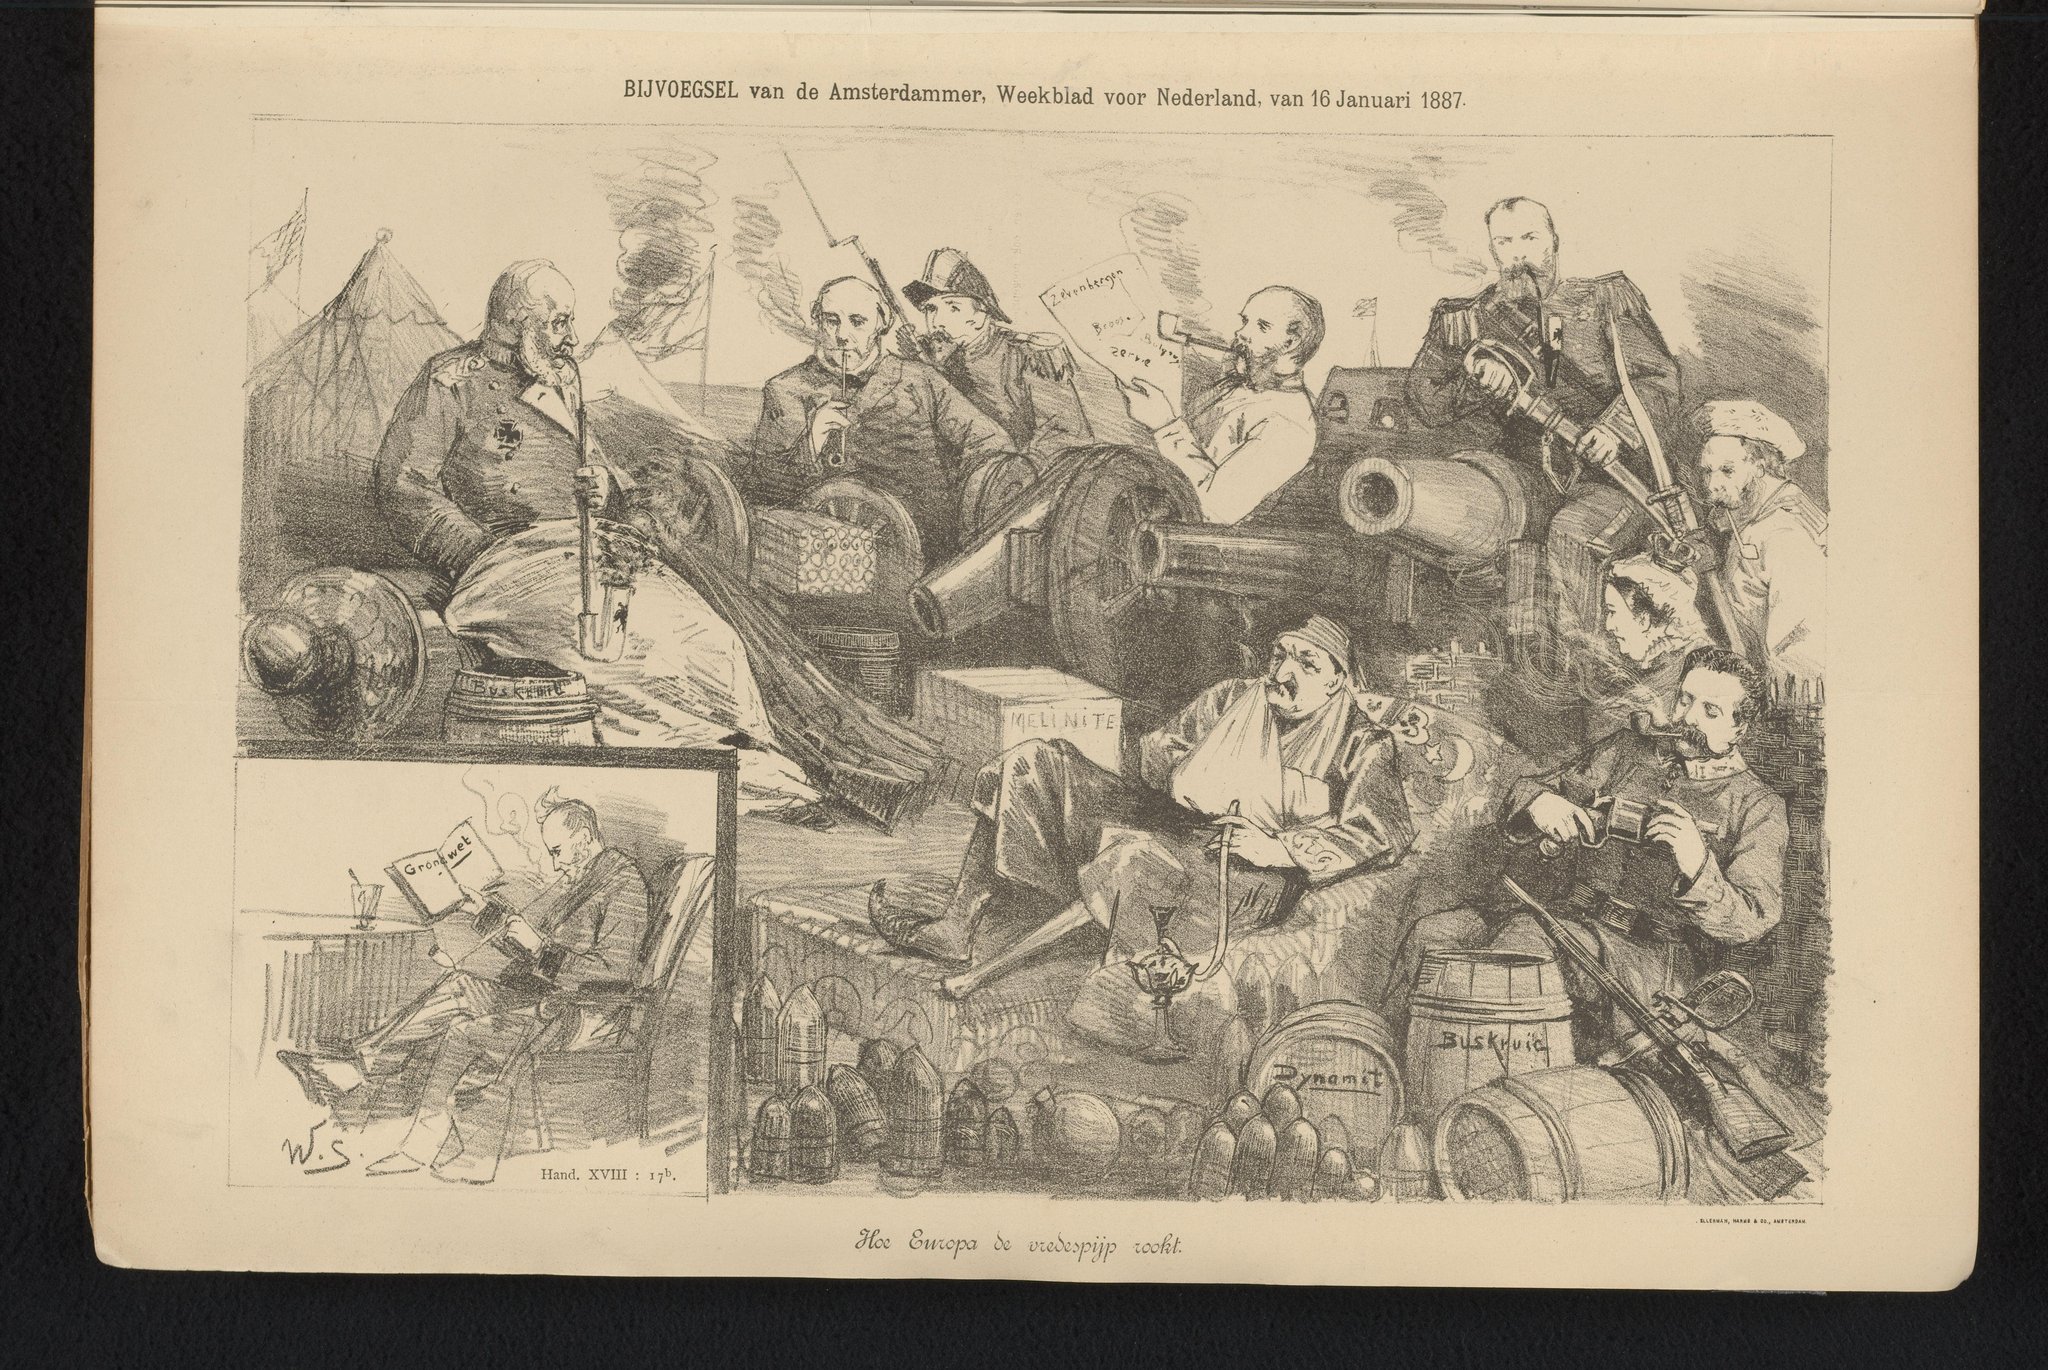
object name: cartoon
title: Hoe Europa de vredespijp rookt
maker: willem steelink (ii)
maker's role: draughtsman, print maker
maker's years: 1856-1928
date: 1887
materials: paper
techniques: lithograph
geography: netherlands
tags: projectiles, explosives, etc.: gunpowder, symbols, allegories of peace, 'pax'; 'pace' (ripa), pipe ~ tobacco, political caricatures and satires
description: Leiders van de Europese landen roken pijpen zittend tussen wapens, granaten en vaten buskruit en dynamiet.